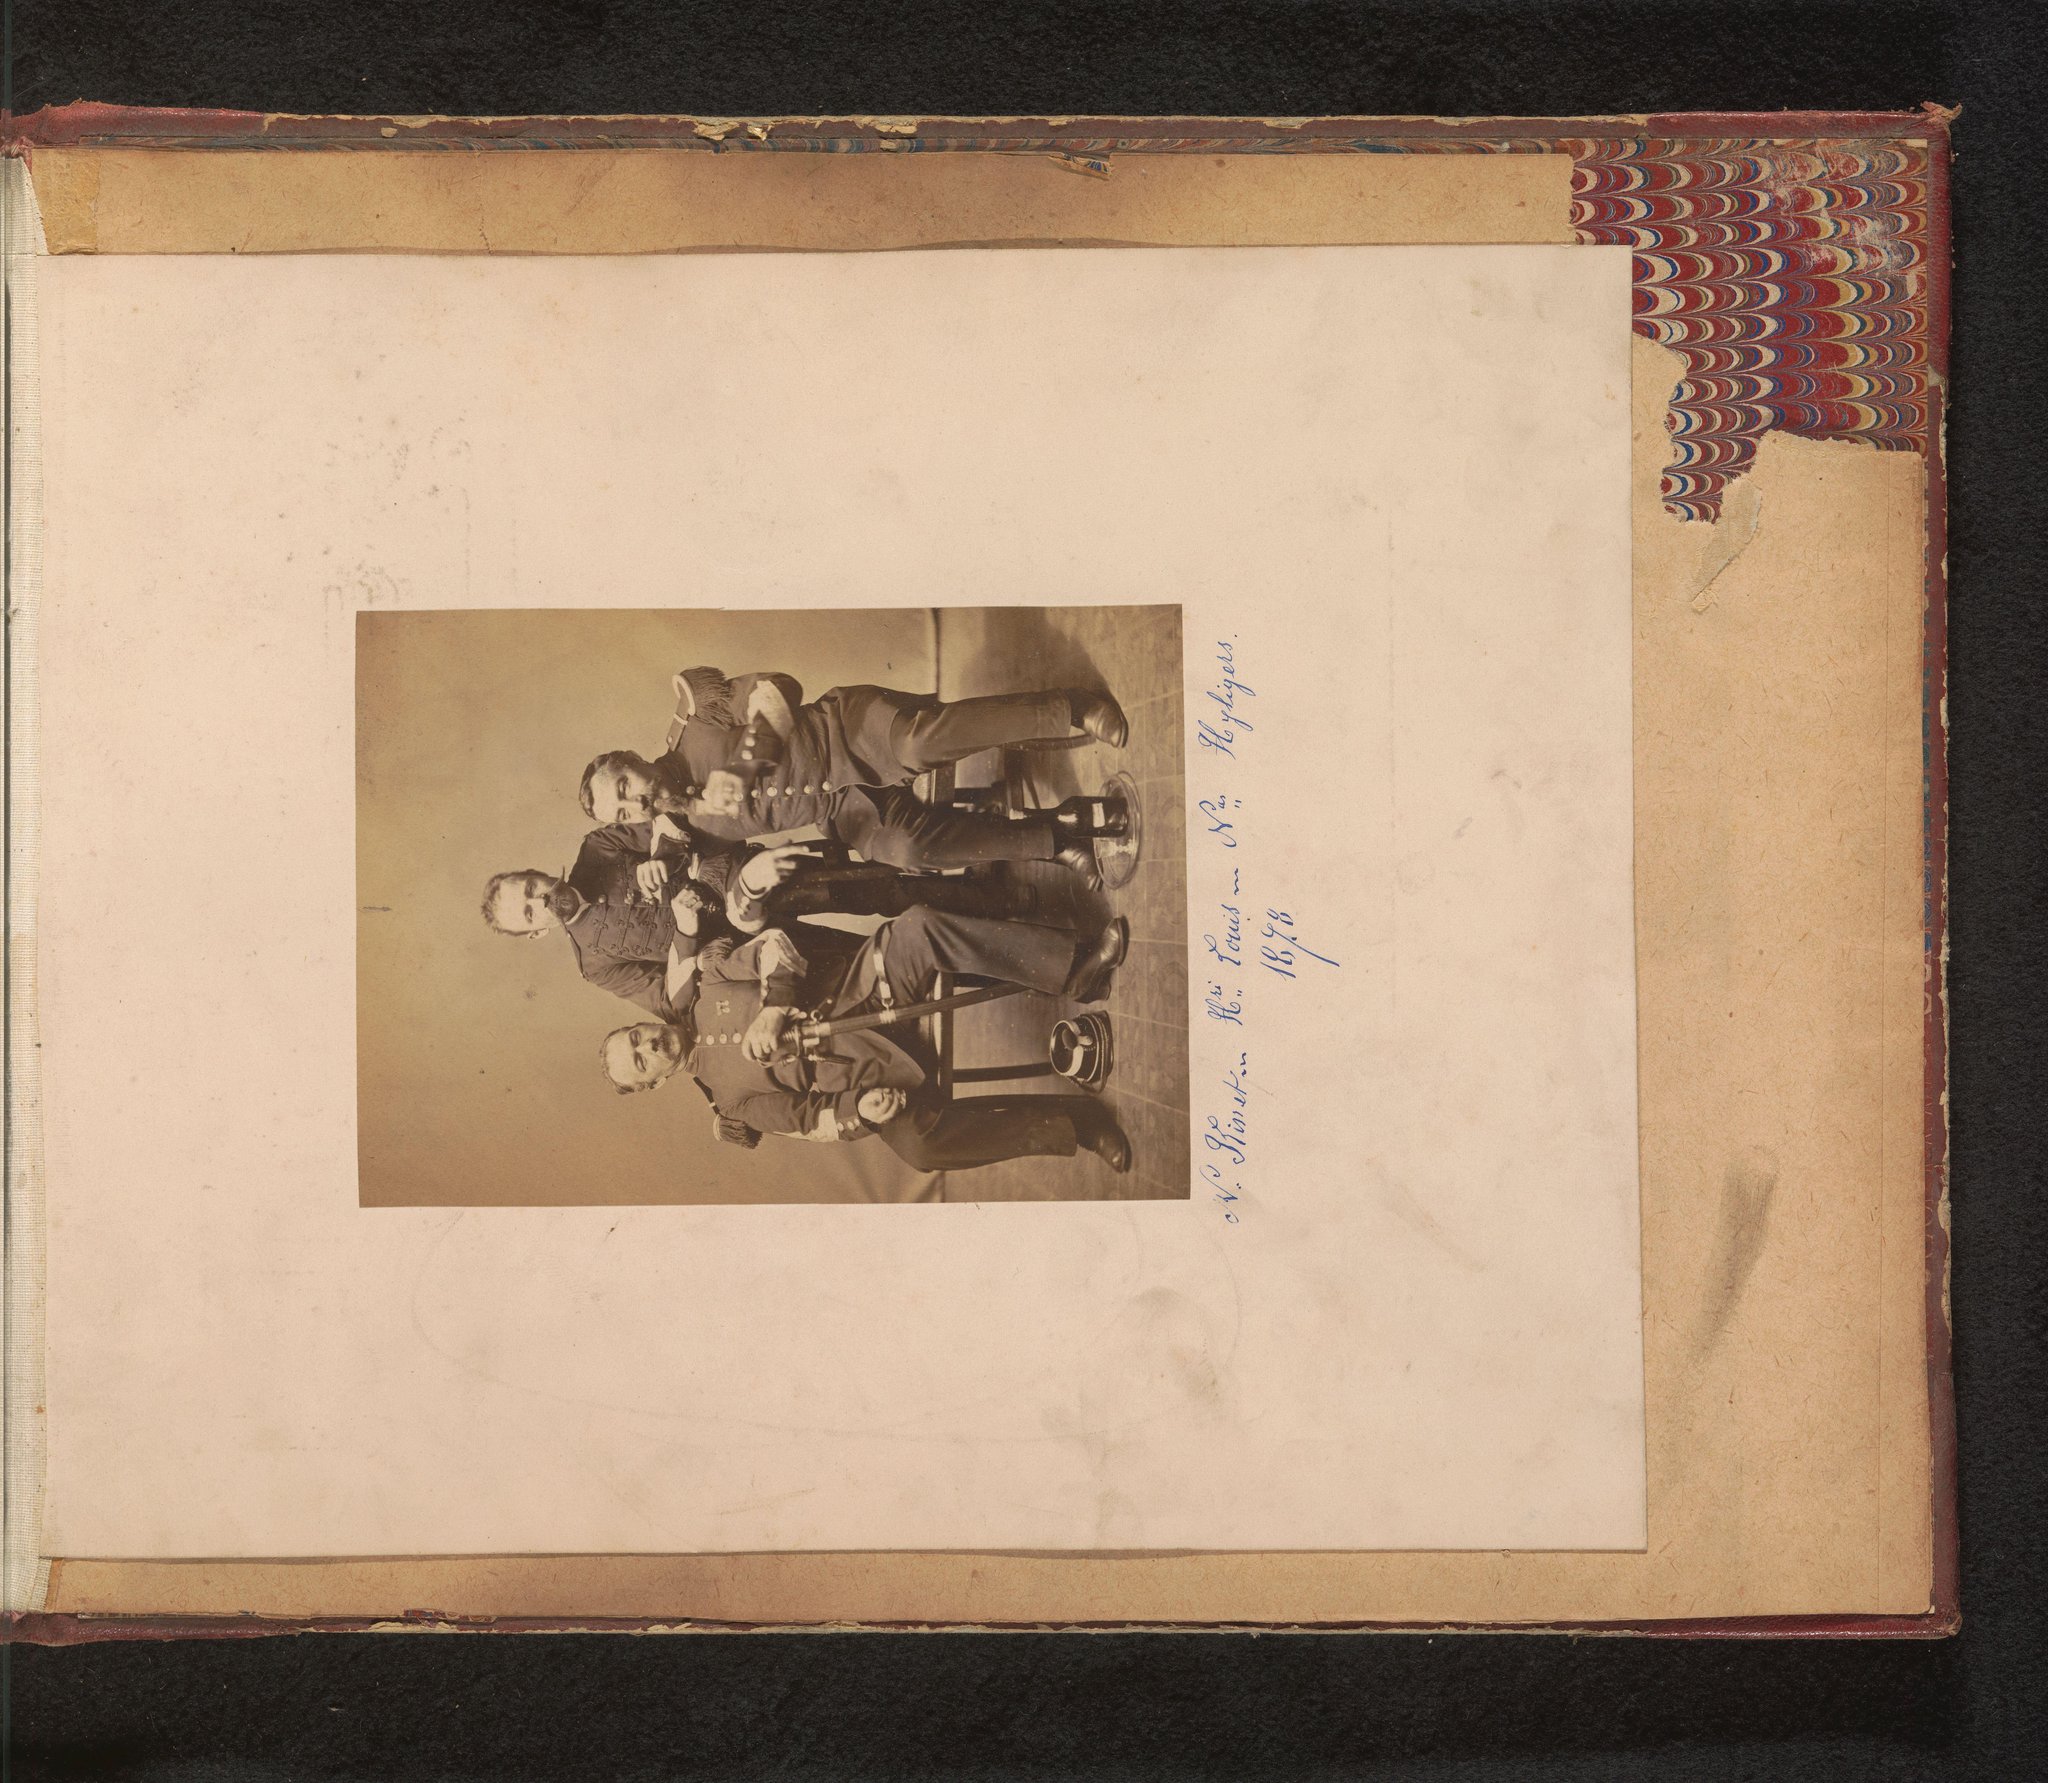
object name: photograph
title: Portret van N. Kinet, Henri Louis en Nicolas Hyligers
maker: Anonymous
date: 1878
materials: photographic support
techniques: albumen print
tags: anonymous historical persons portrayed in a group, in a group-portrait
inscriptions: annotation: ‘N. Kinet ~ Hri Louis ~ Nas Hyligers./ 1878’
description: Dit portret van de eigenaar van het boek met twee collega's is achterin het album toegevoegd.